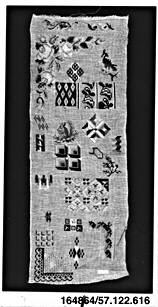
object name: sampler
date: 1801-1900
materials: canvas, silk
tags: birds